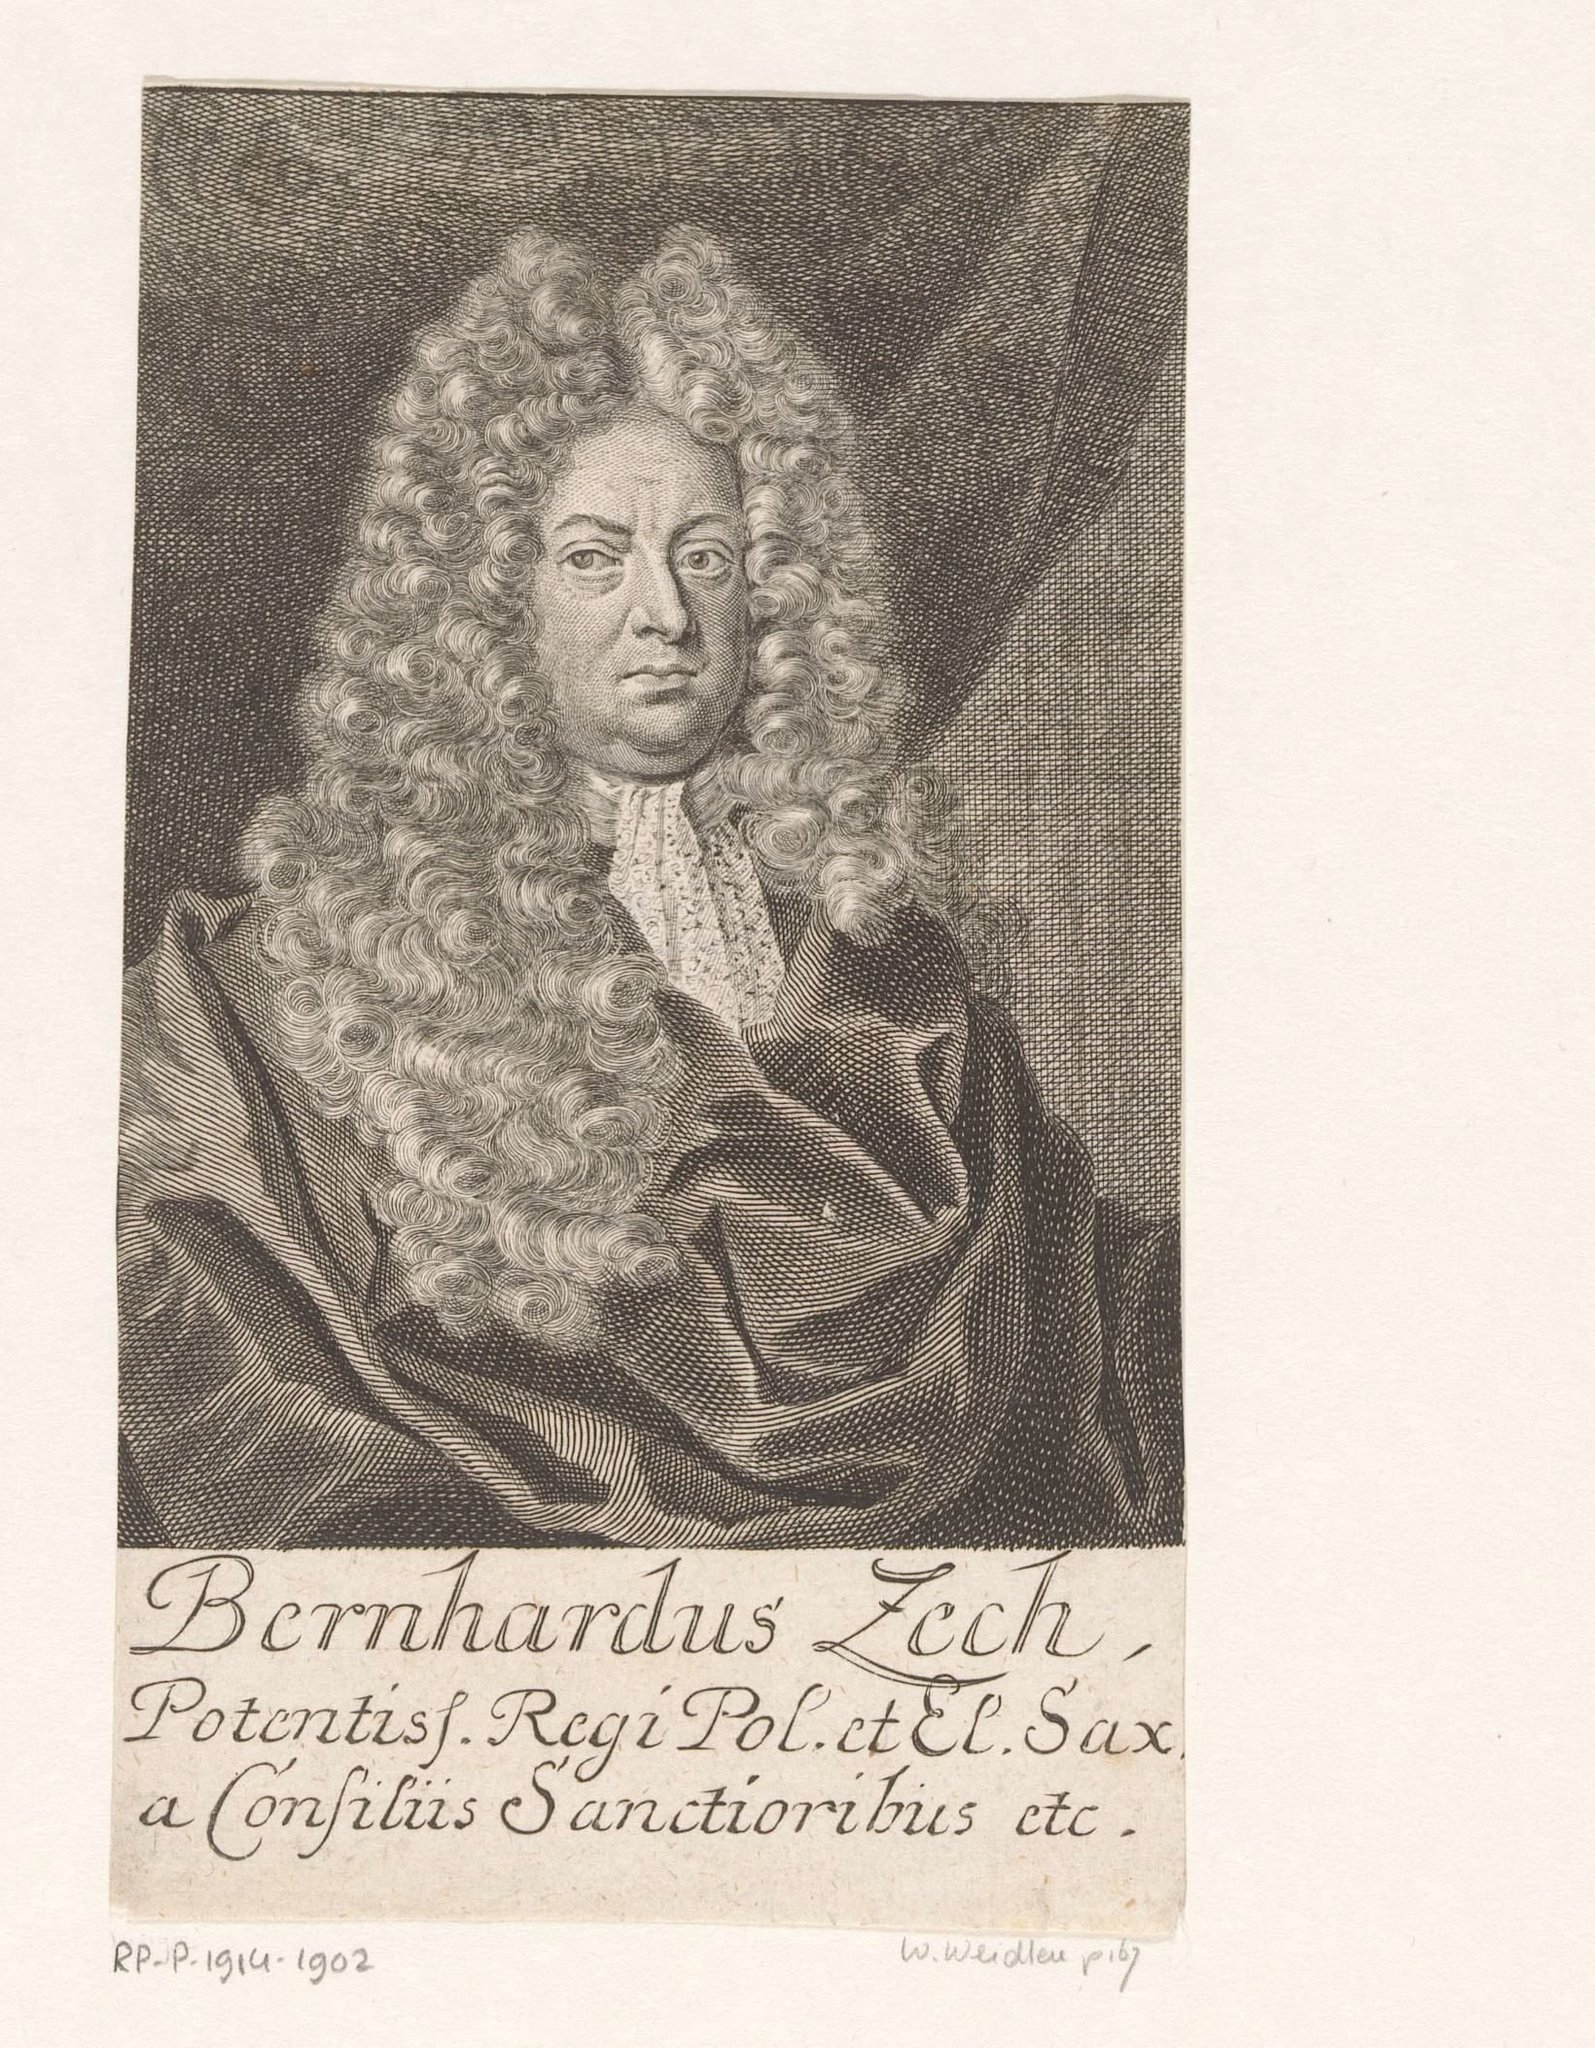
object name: print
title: Portret van Bernhard von Zech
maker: martin bernigeroth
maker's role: print maker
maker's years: 1670-1733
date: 1713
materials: paper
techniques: engraving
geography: leipzig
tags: historical persons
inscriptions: collector's mark: Lugt 2228